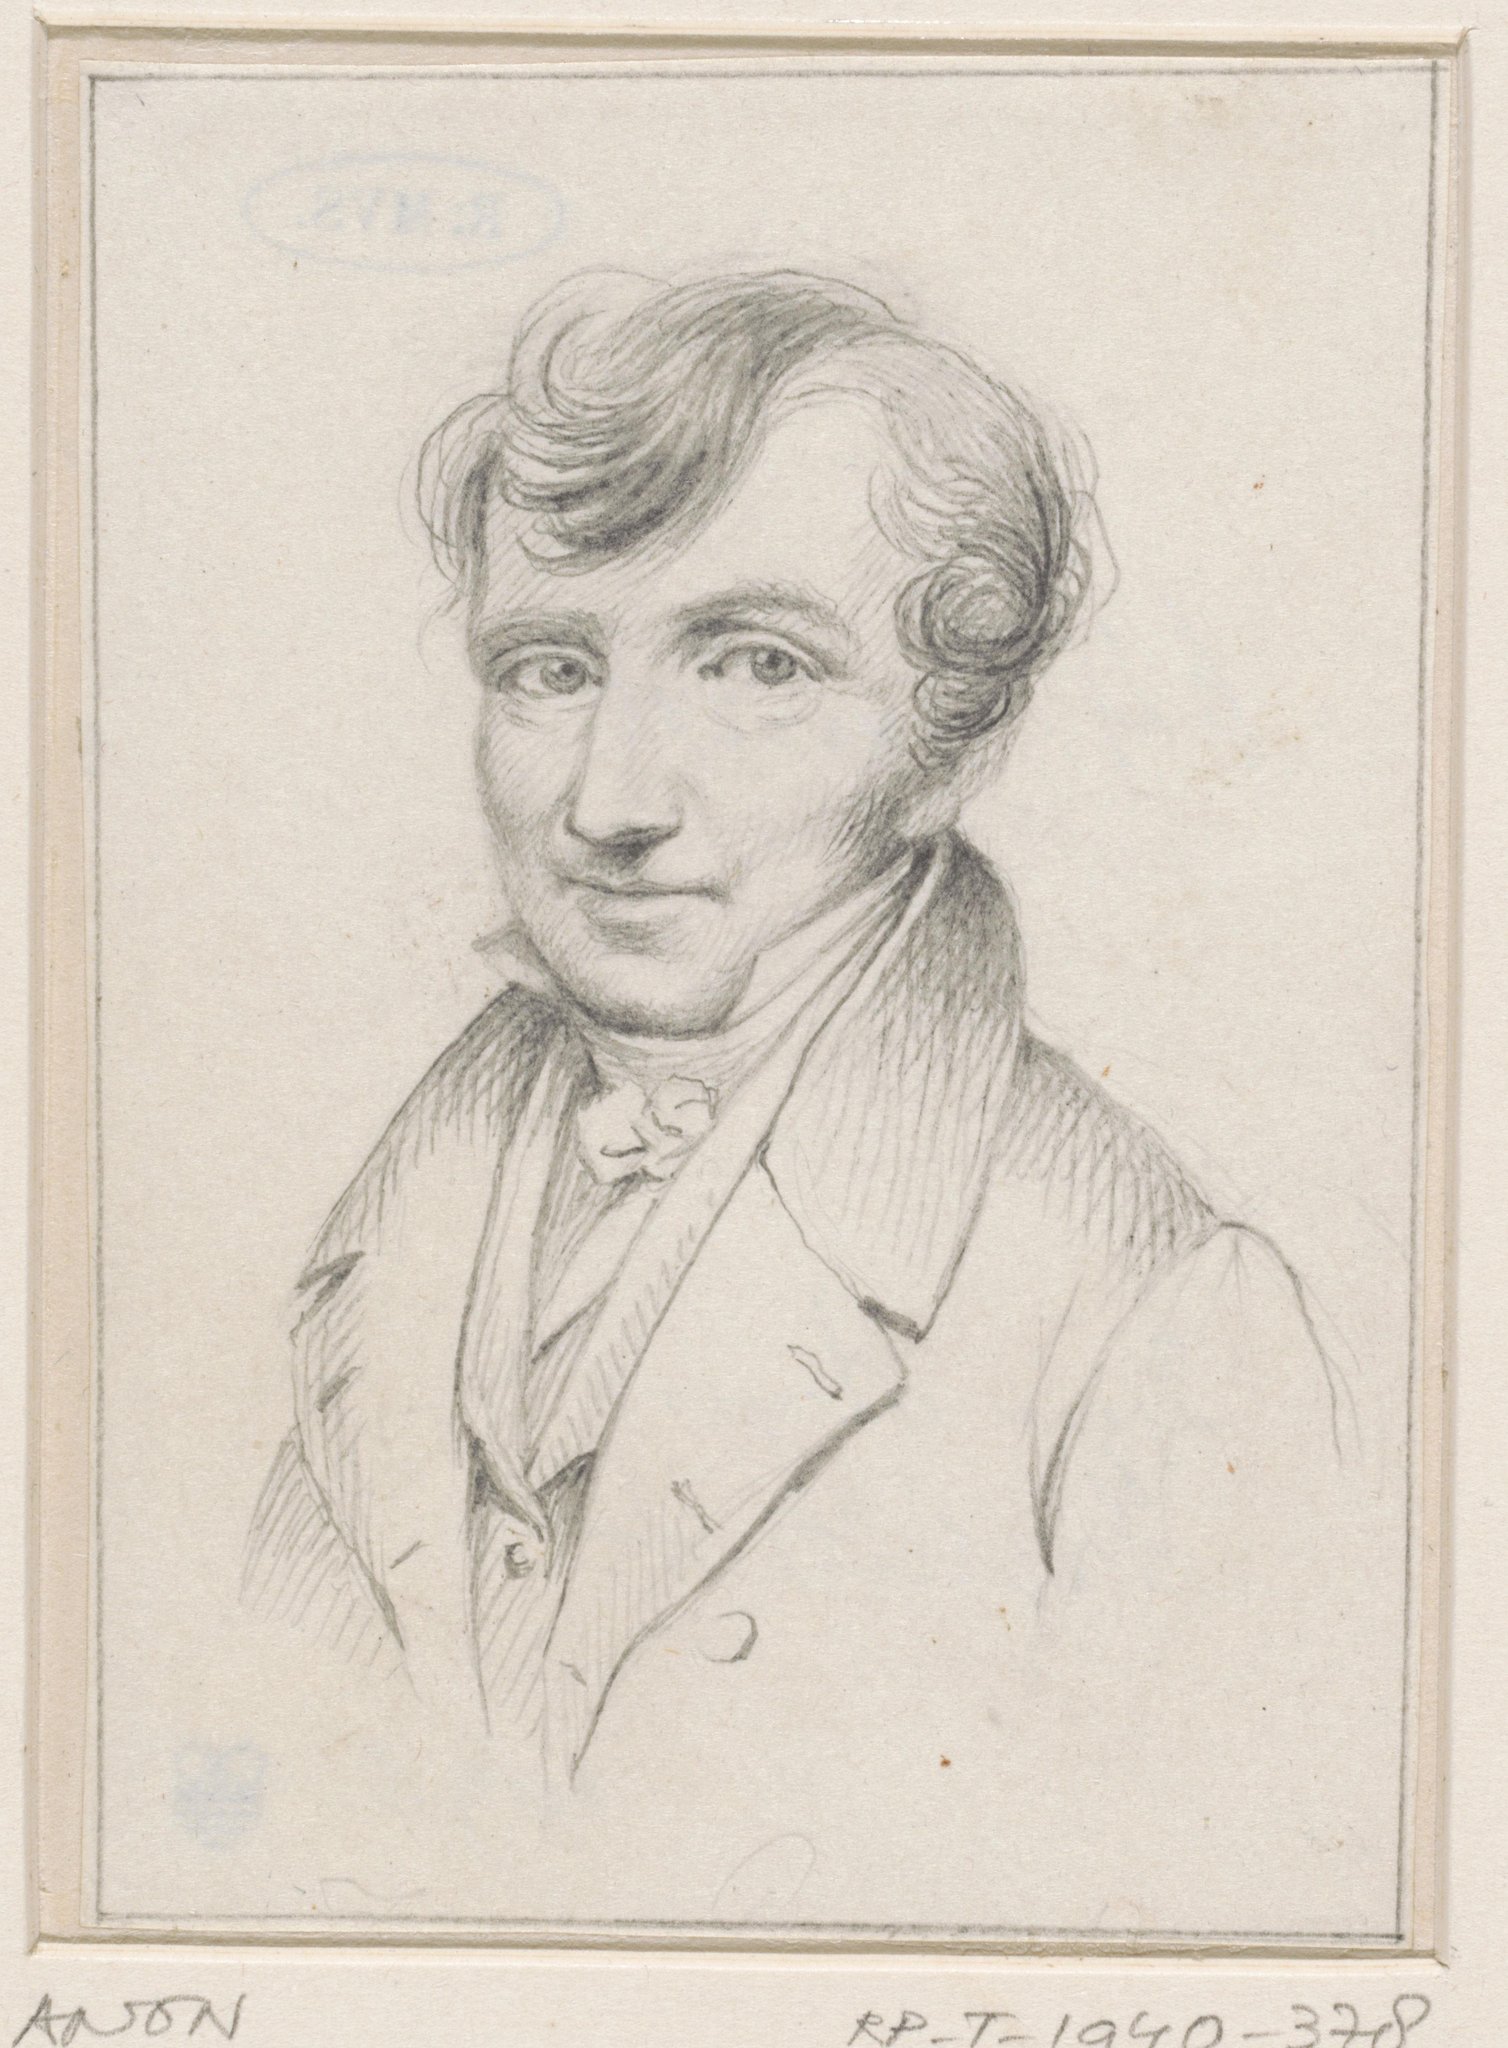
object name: drawing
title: Portret van Zeger Otz Reyers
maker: Anonymous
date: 1800-1907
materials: paper, pencil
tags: arnhem, the hague, draughtsman, zeger otz reyers, historical persons, portrait, self-portrait of artist